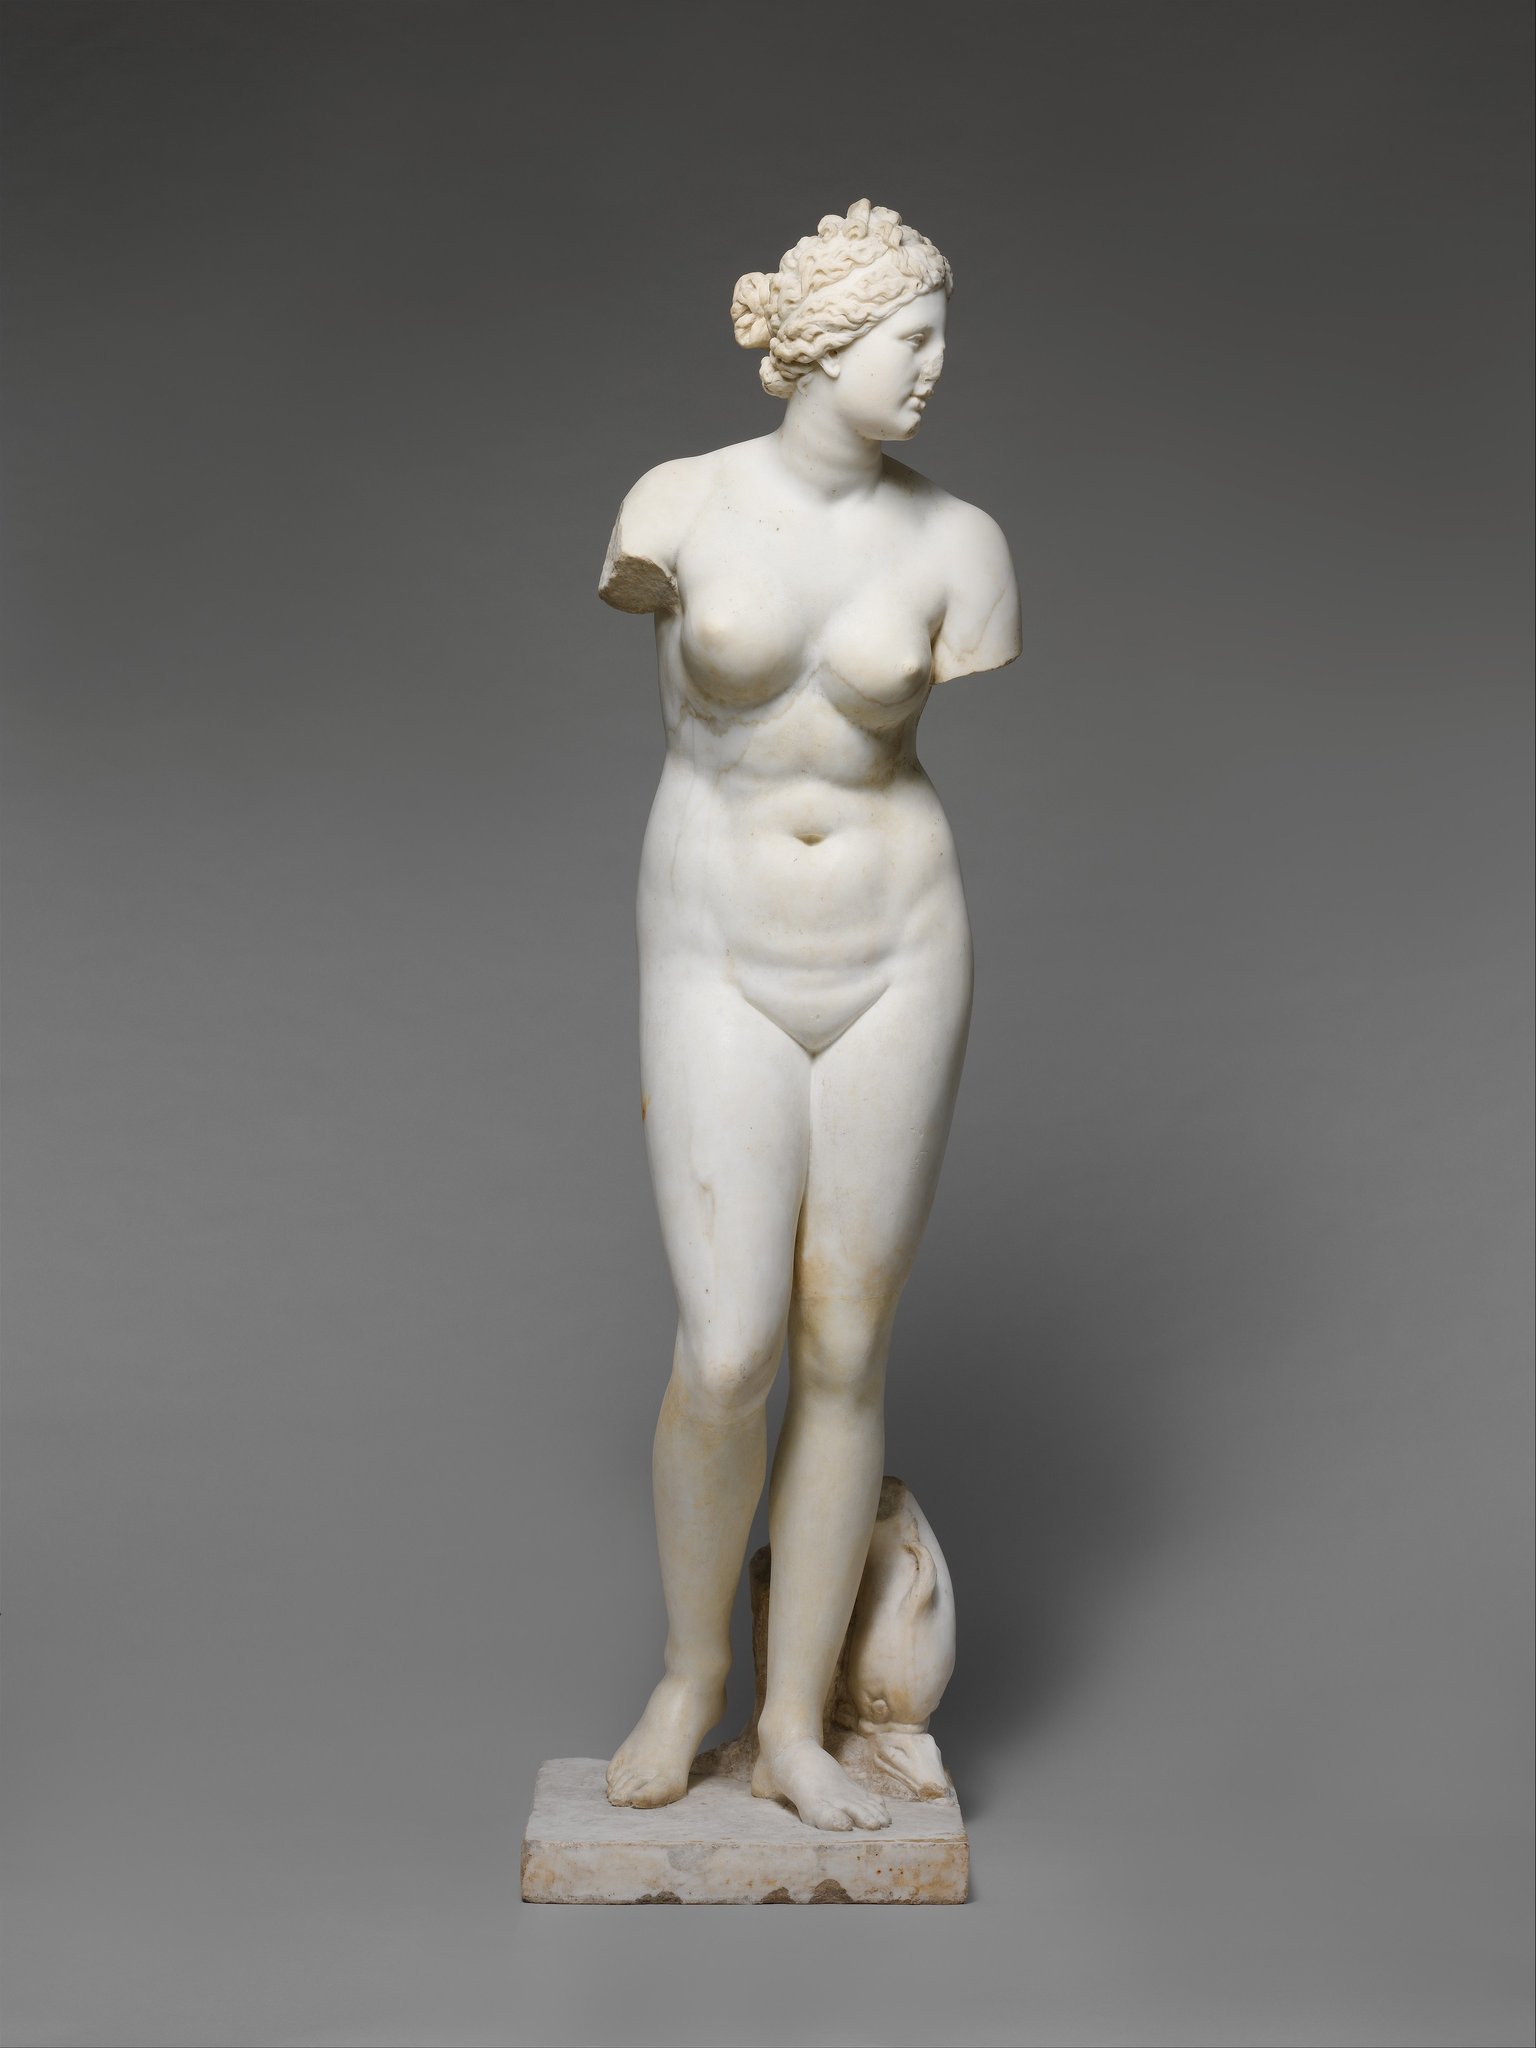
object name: statuette of aphrodite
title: Marble statue of Aphrodite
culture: roman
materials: marble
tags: female nudes,aphrodite